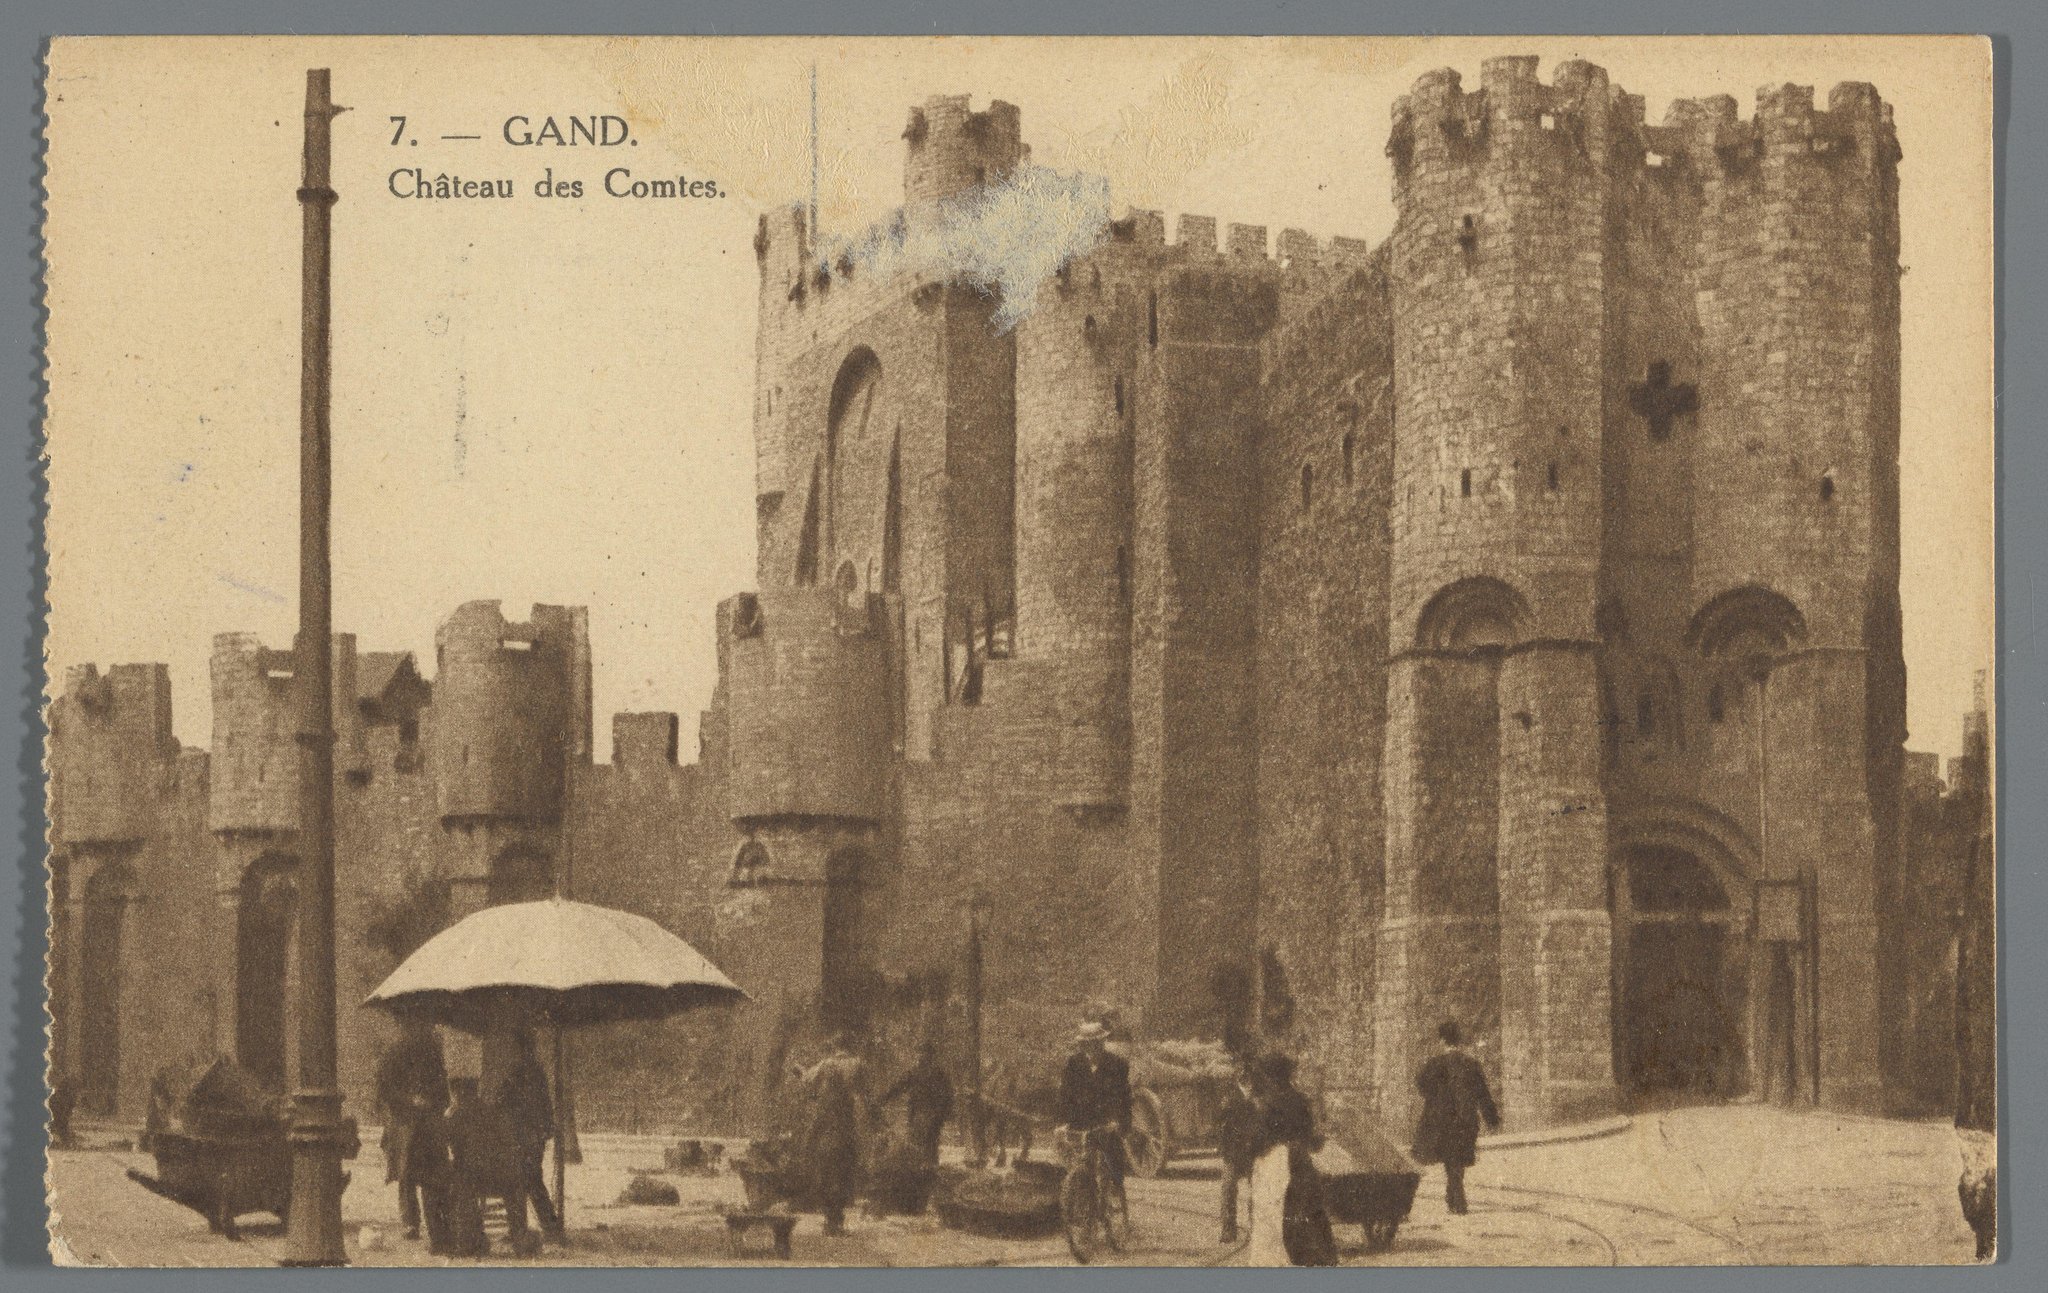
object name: postcard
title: Gand, Château des Comtes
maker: marco marcovici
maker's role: publisher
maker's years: 1873-1938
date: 1920-1950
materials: photographic support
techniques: rotogravure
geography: brussels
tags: ghent